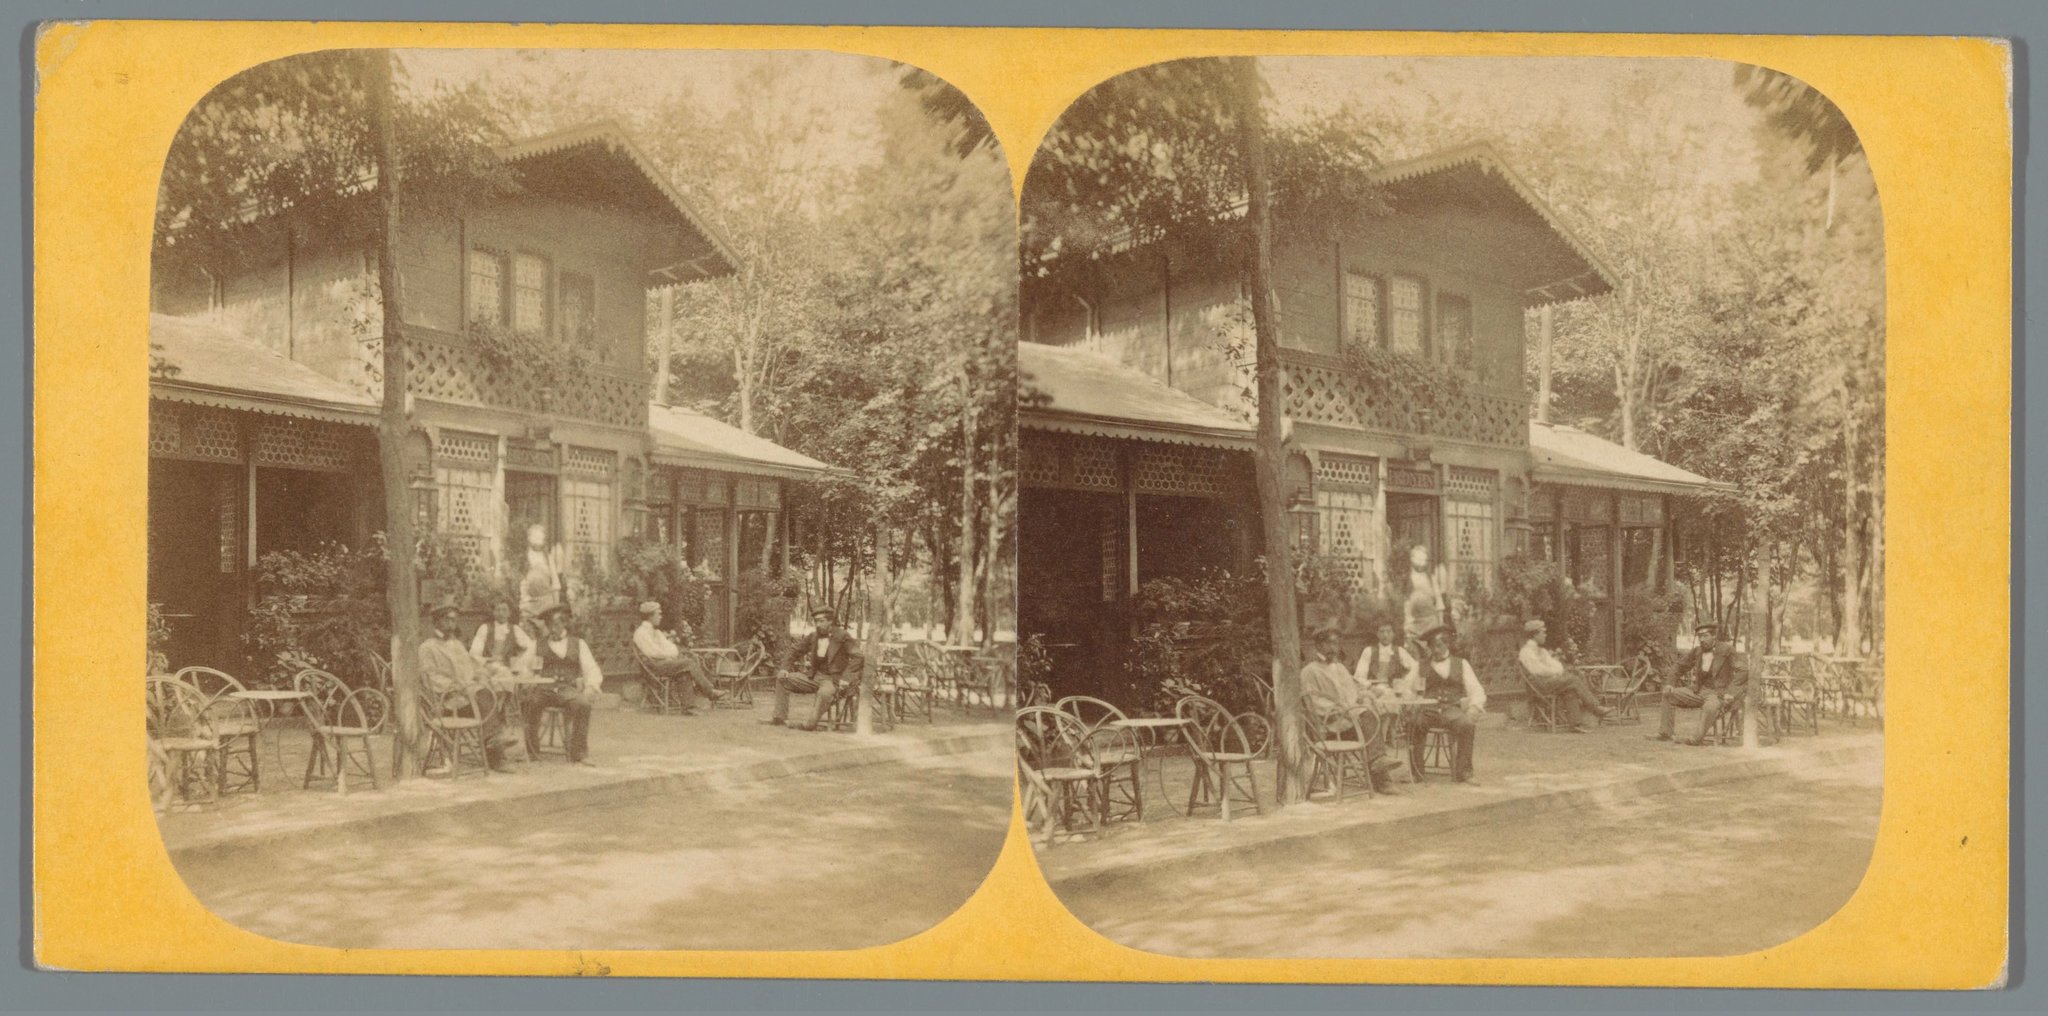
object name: stereograph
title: Gezicht op een café in het Bois de Boulogne in Parijs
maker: Anonymous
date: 1850-1880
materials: cardboard, photographic support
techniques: albumen print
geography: bois de boulogne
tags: inn, coffee-house, public house, etc., pavement, terrace in front of inn or restaurant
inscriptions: inscription: ‘Bois de Boulogne-café- Paris instantané’, number: ‘No 64 No. 67 XXV’